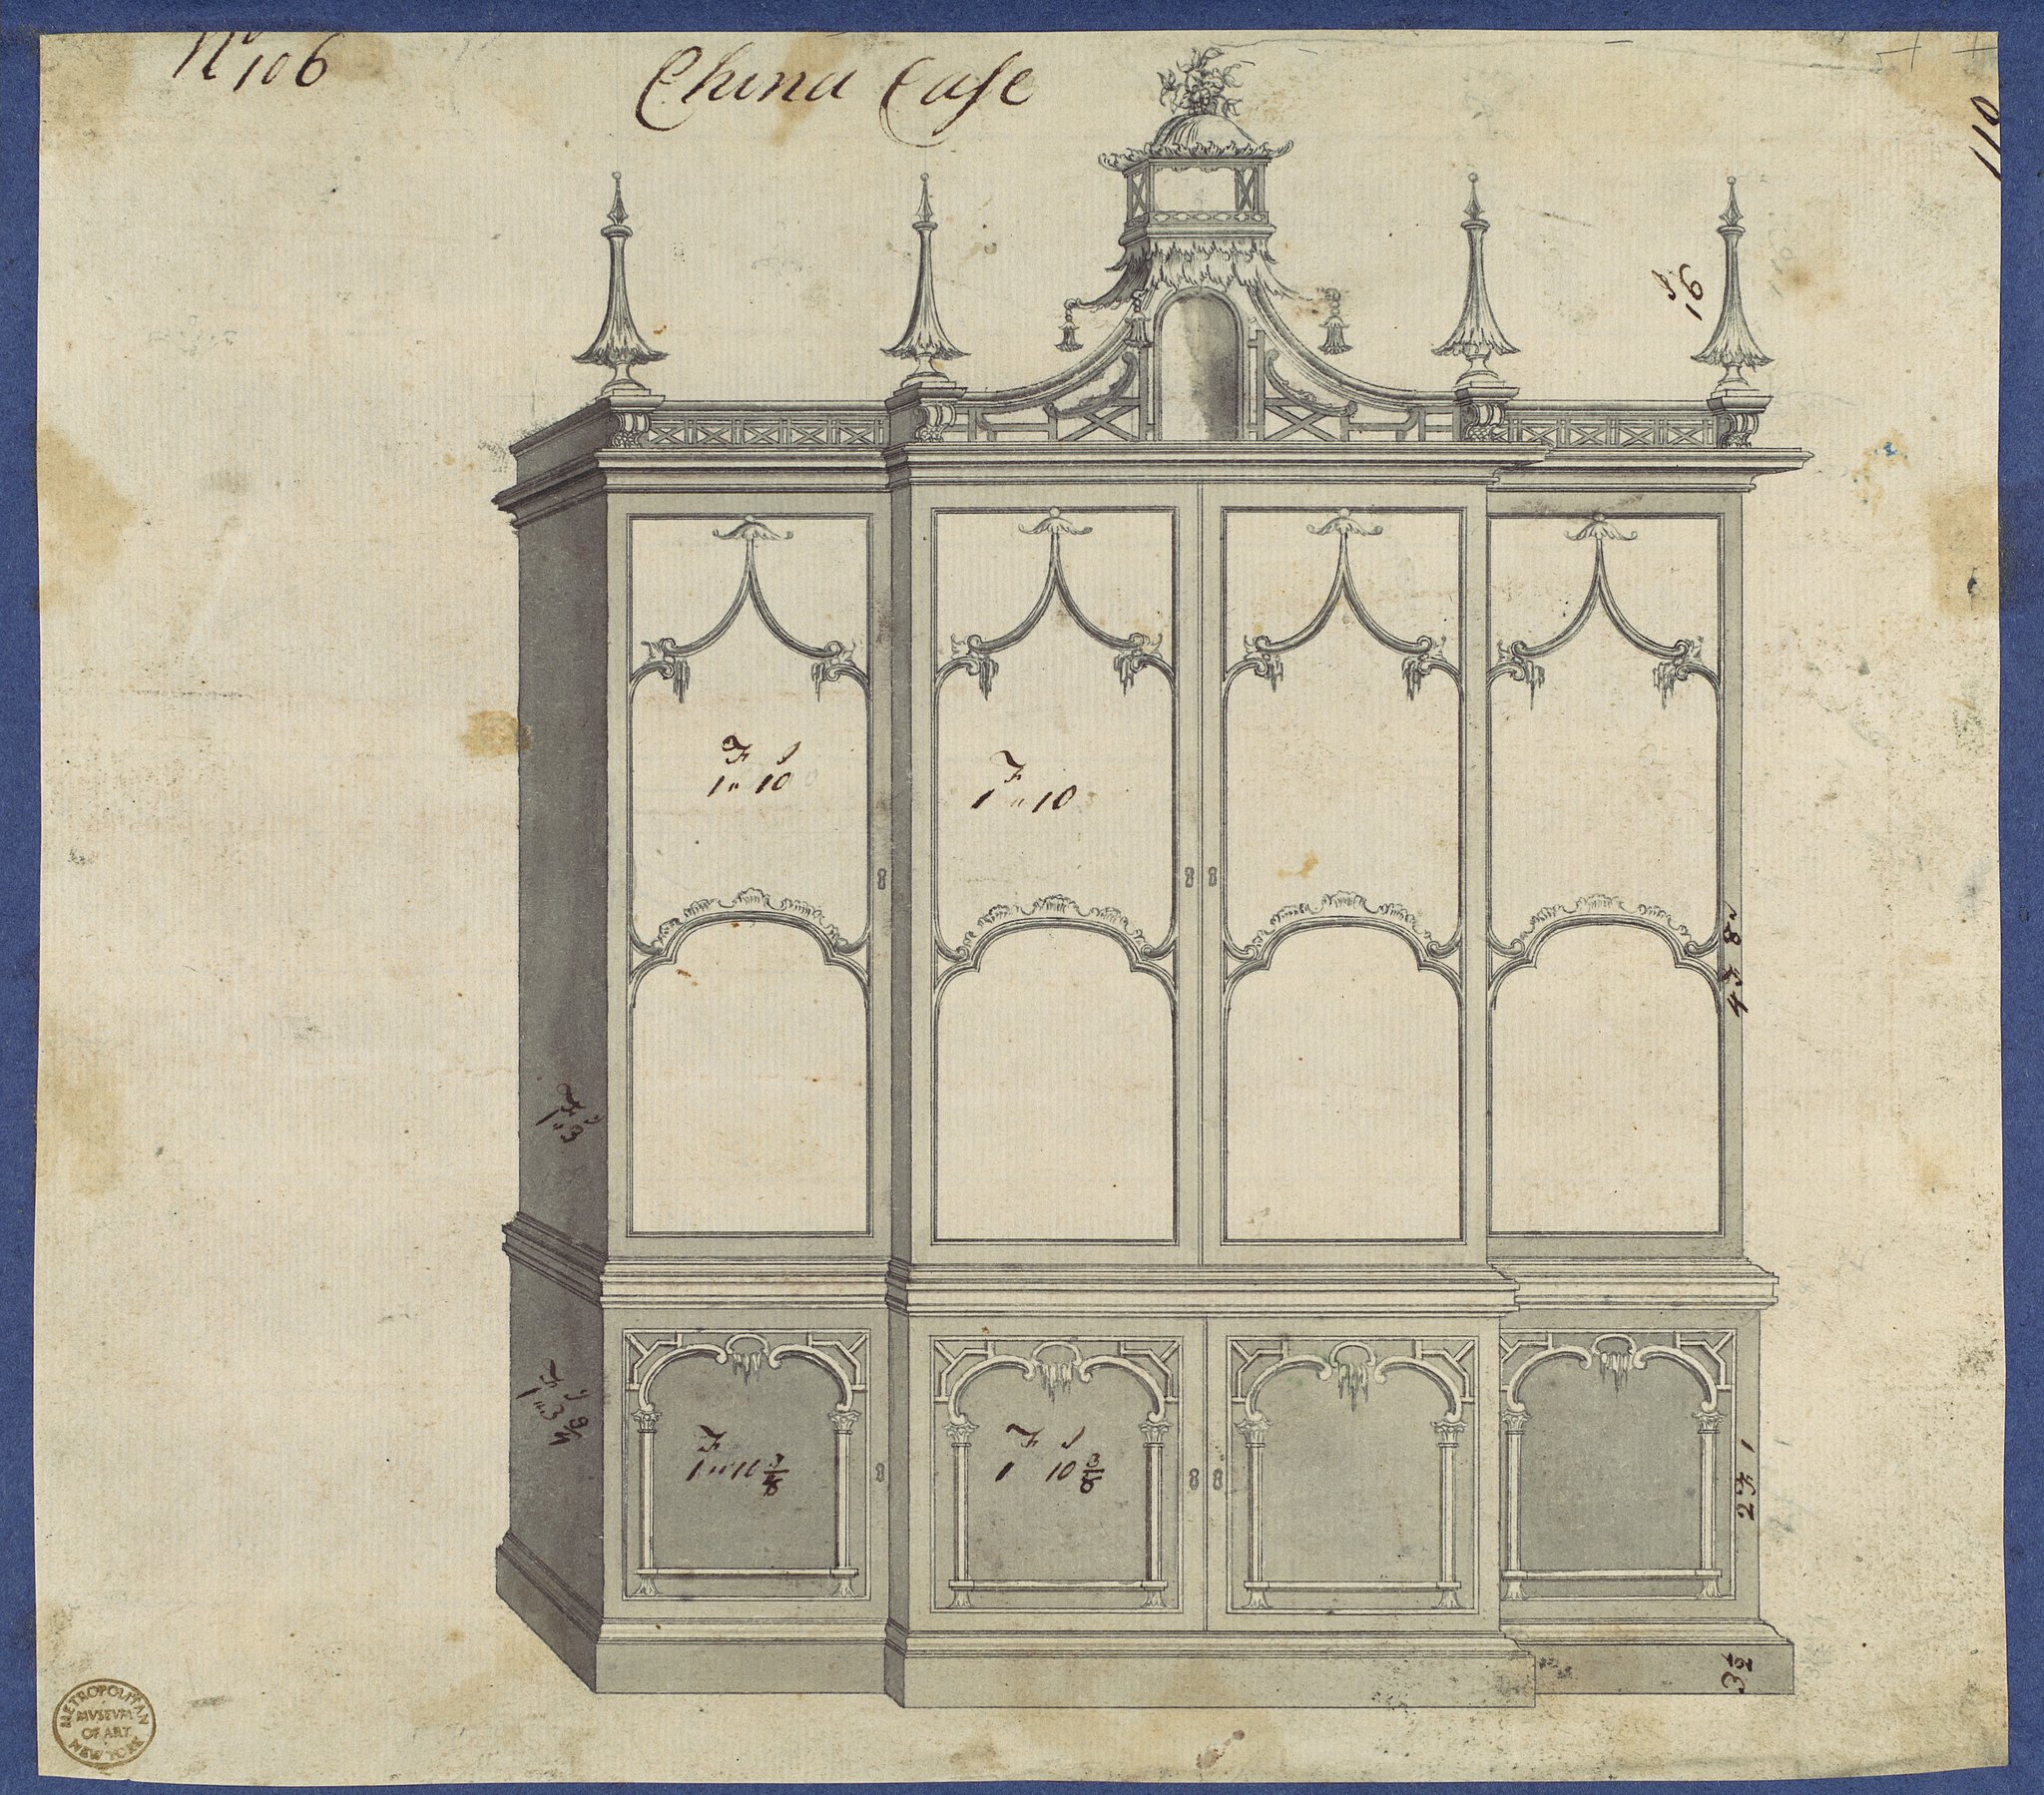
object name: drawing ornament architecture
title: China Case, from Chippendale Drawings, Vol. II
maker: thomas chippendale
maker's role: artist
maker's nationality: british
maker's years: 1718-1779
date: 1753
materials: ink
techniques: wash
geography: london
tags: furniture